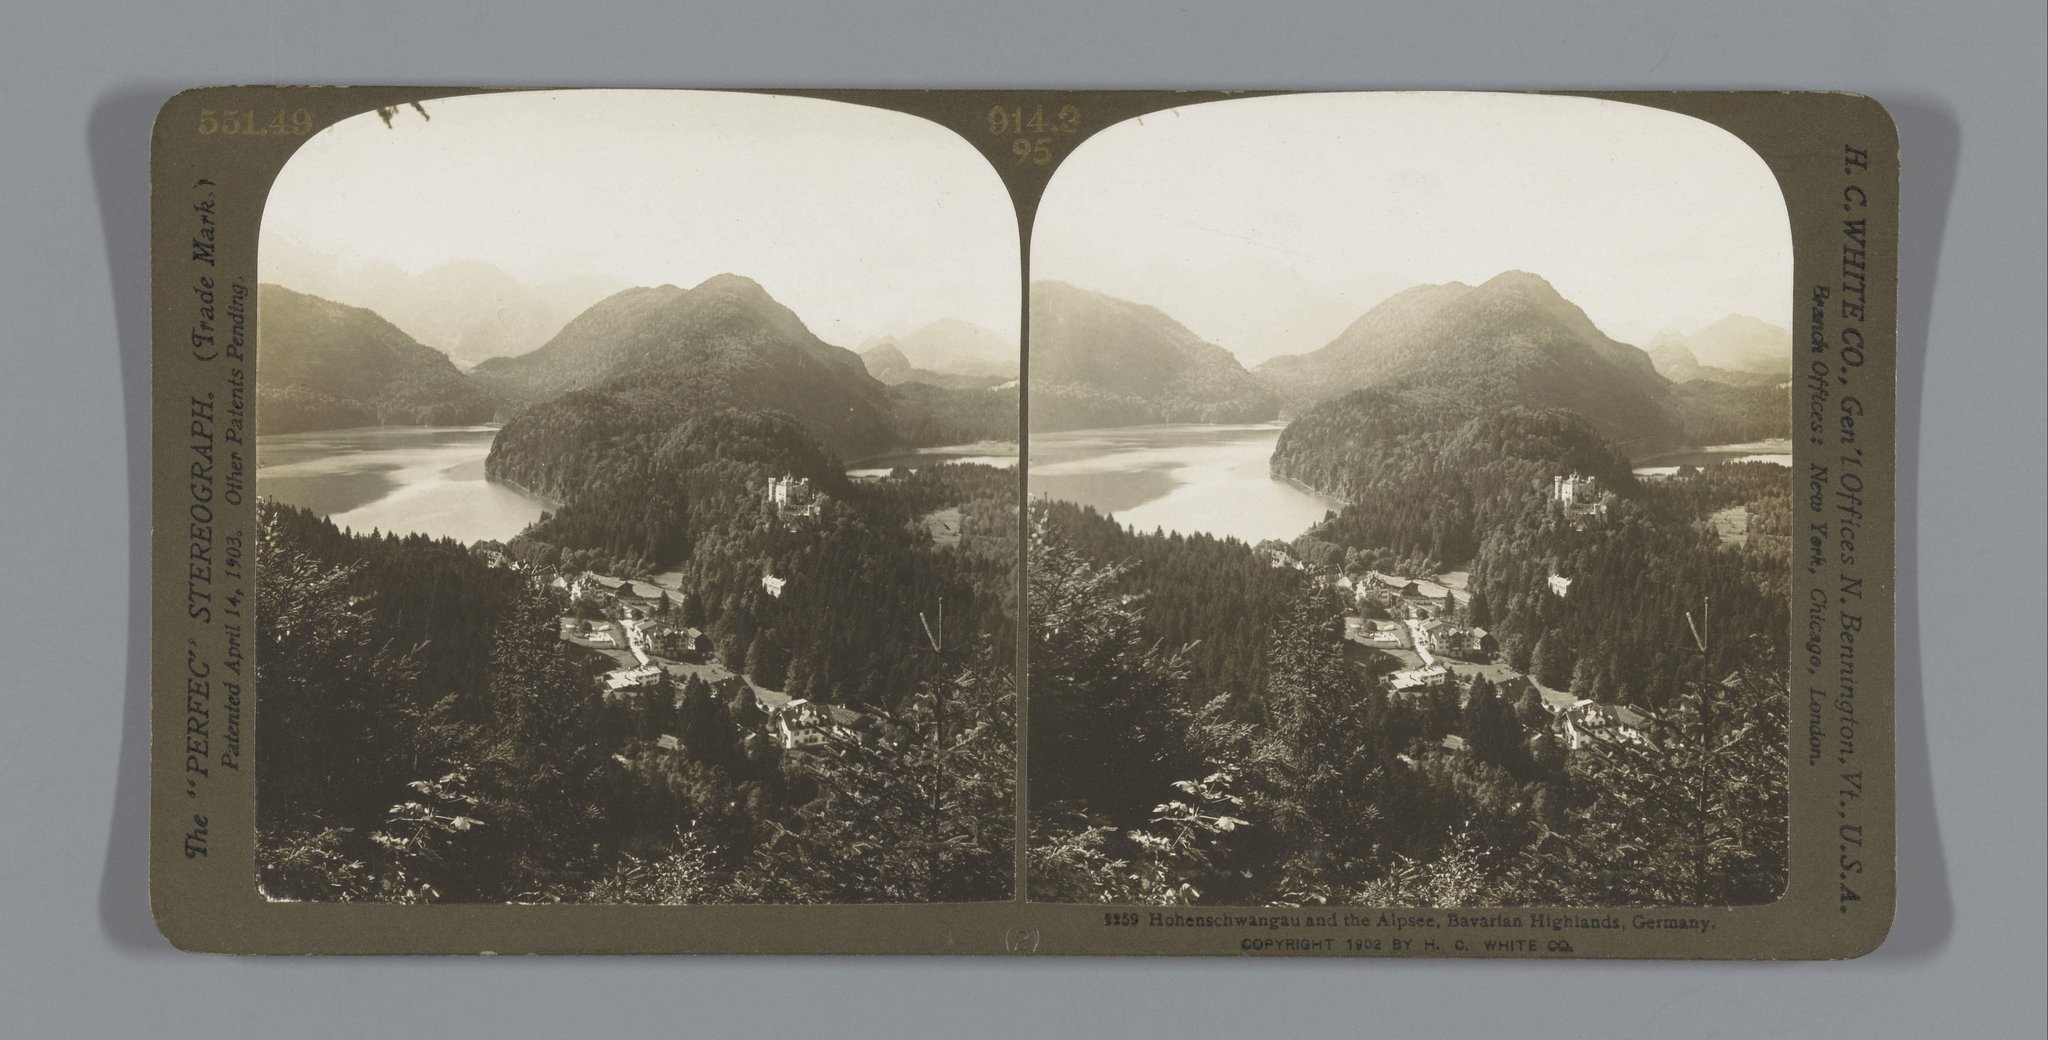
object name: stereograph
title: Hohenschwangau and the Alpsee, Bavarian Highlands, Germany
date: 1902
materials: cardboard, photographic support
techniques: gelatin silver print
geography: bavaria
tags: castle, lake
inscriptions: inscription: ‘Hohenschwangau and the Alpsee, Germany. (...) See Baedeker's Eastern Alps.’, inscription: ‘H. C. White Co., Gen't Offices N. Bennington, Vt., U.S.A. Branch Offices: New York, Chicago, London.’, number: ‘551.49 914.3 95’, number: ‘2259’